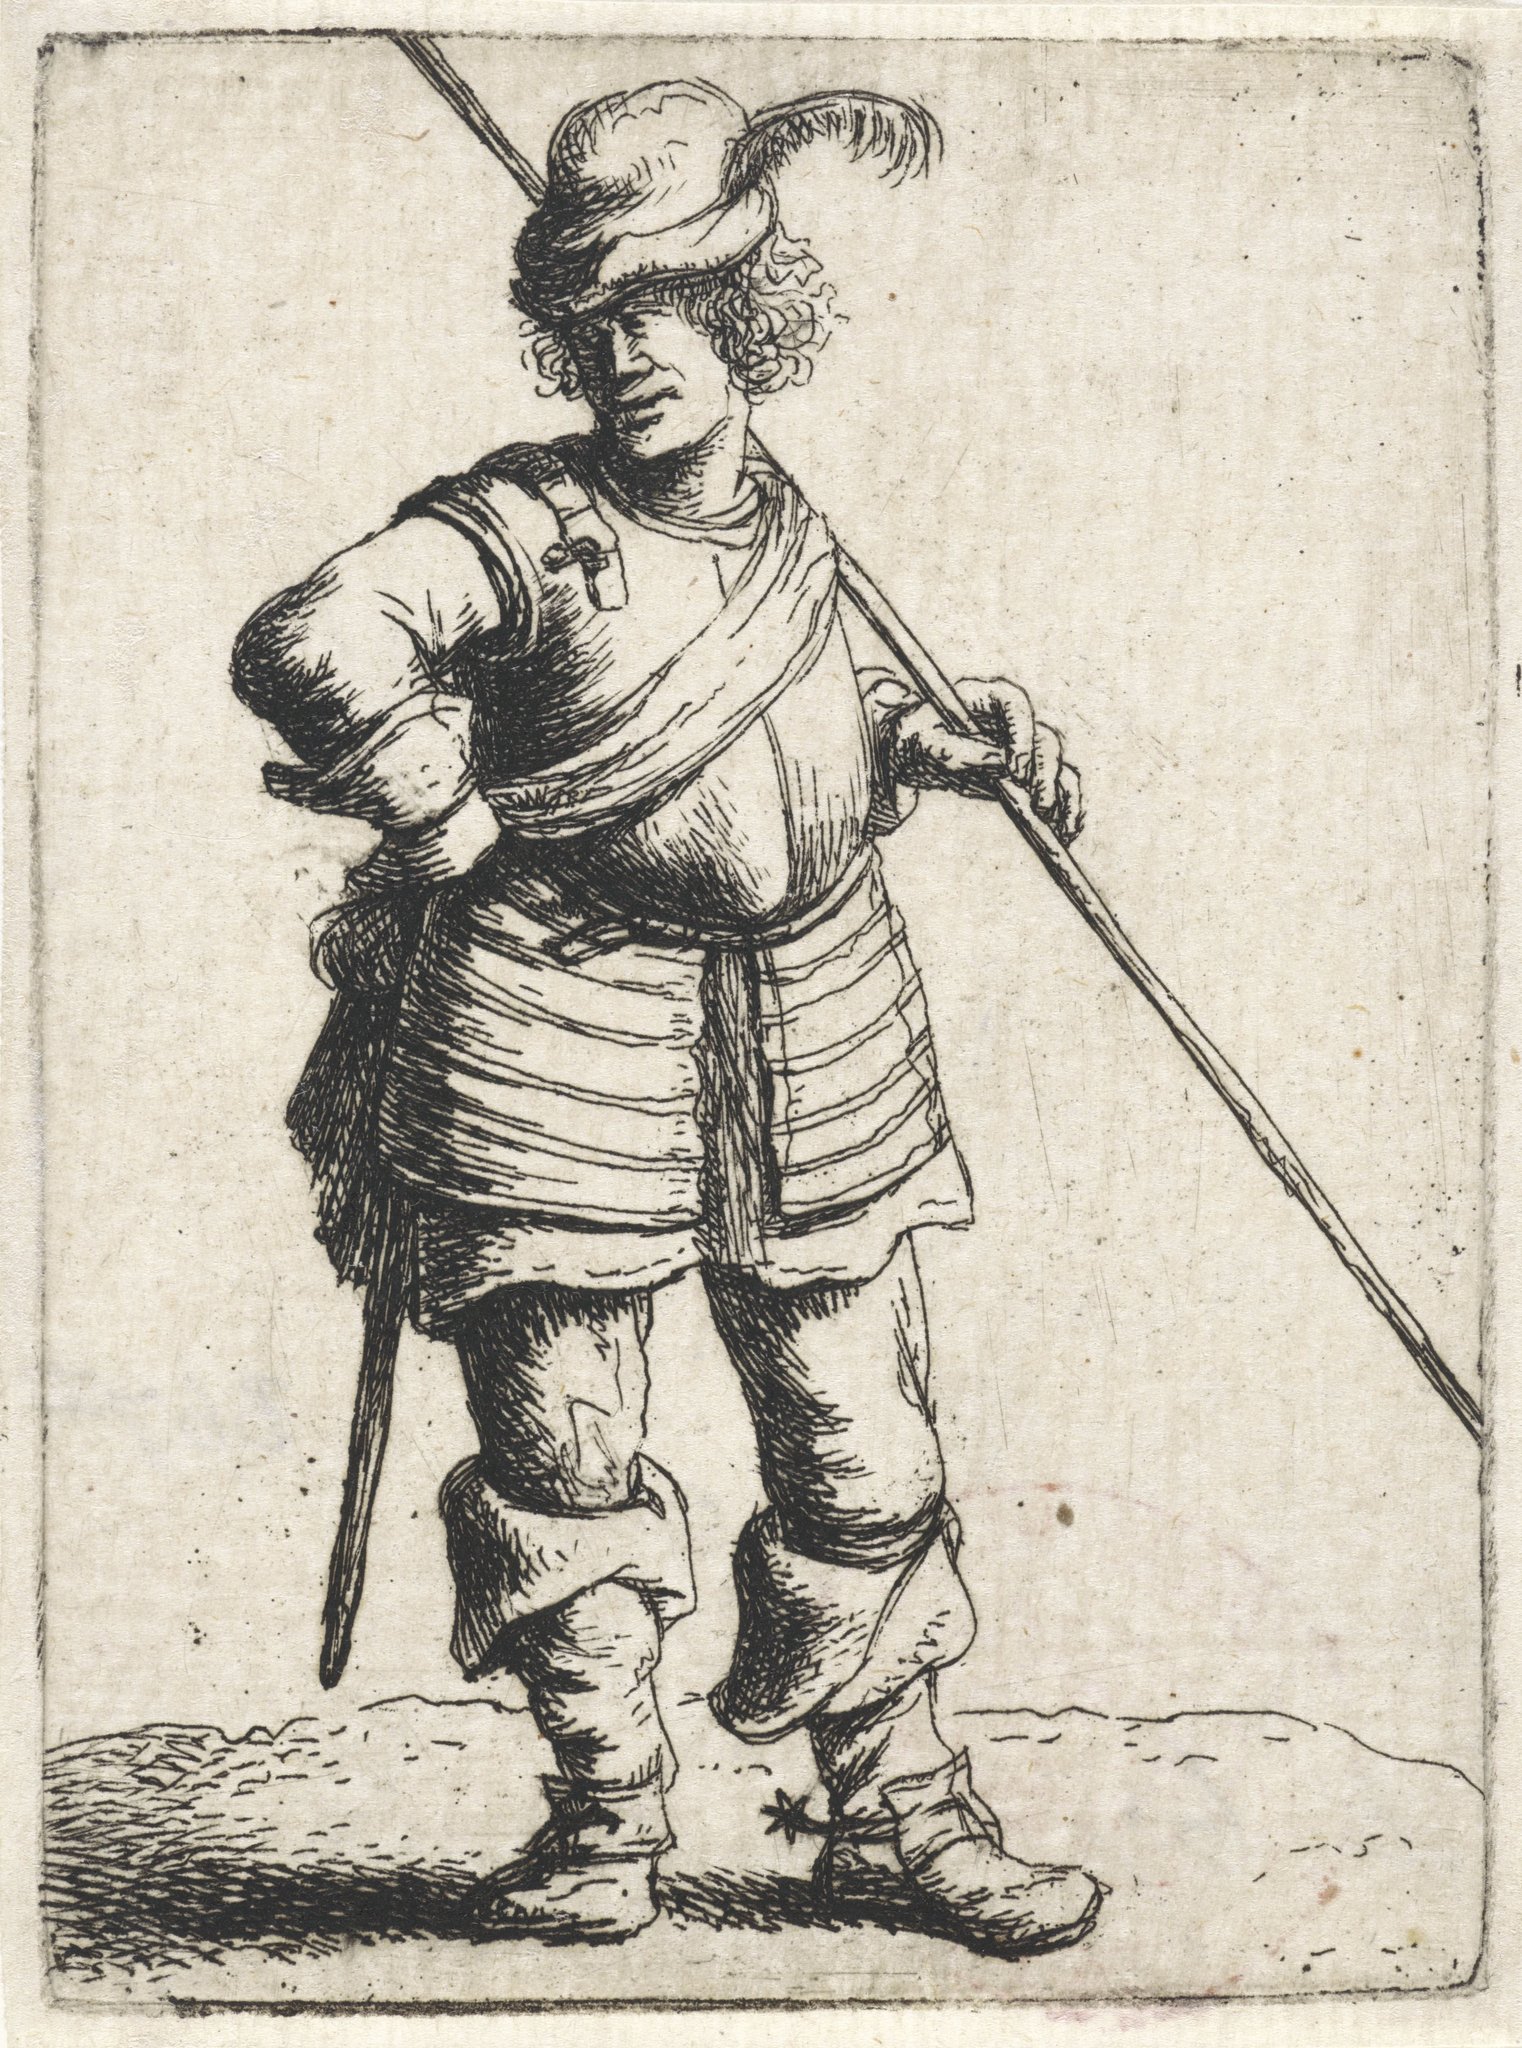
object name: print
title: Piekenier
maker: jan gillisz. van vliet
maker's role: draughtsman, painter, print maker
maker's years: 1600-1668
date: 1635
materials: paper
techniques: etching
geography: leiden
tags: helved weapons, polearms (for striking, hacking, thrusting): pike, the soldier; the soldier's life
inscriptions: collector's mark: Lugt 240